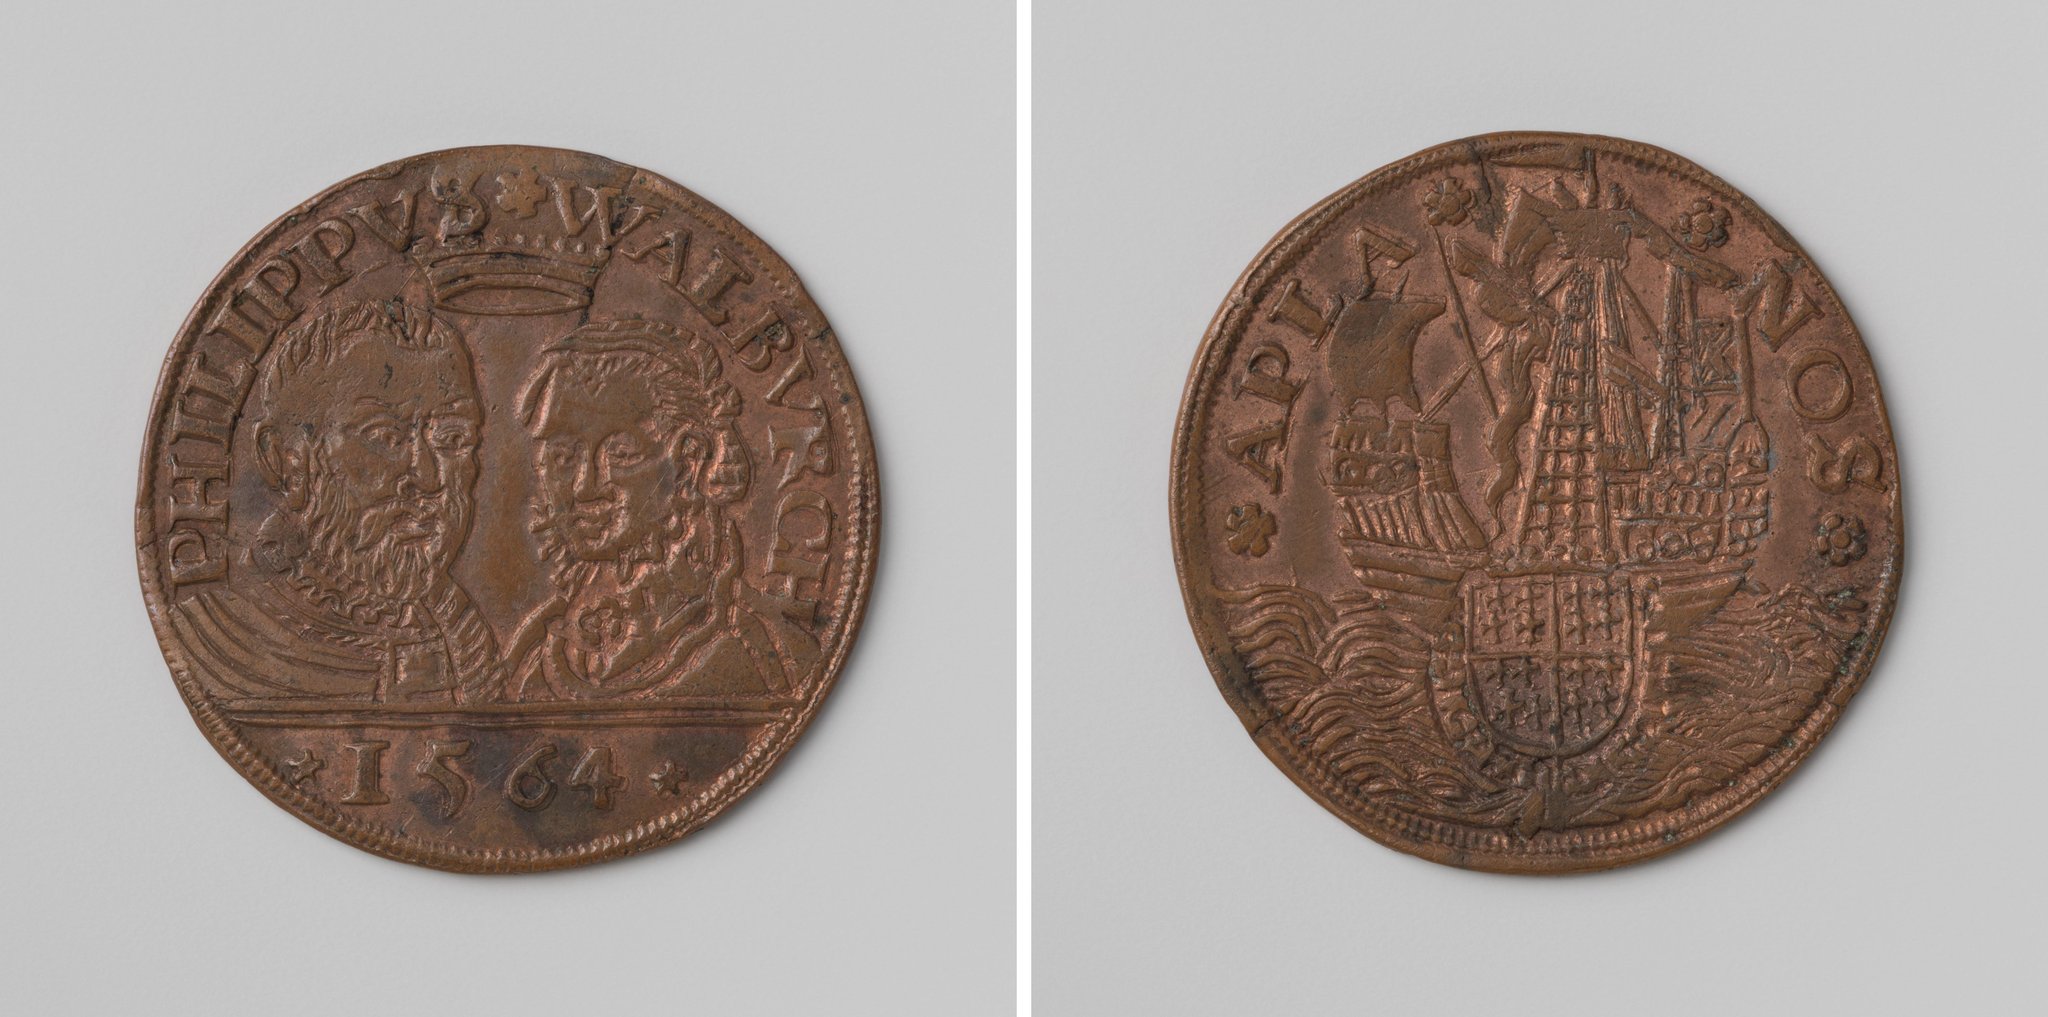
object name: jeton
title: Filips van Montmorency, graaf van Horne en zijn vrouw Walburg van Nieuwenaar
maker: Anonymous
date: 1564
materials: copper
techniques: striking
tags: brussels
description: Koperen penning. Voorzijde: borststukken man en vrouw onder kroon binnen omschrift; afsnede: jaartal. Keerzijde: schip op zee boven wapenschild, omhangen met orde van Gulden Vlies binnen omschrift